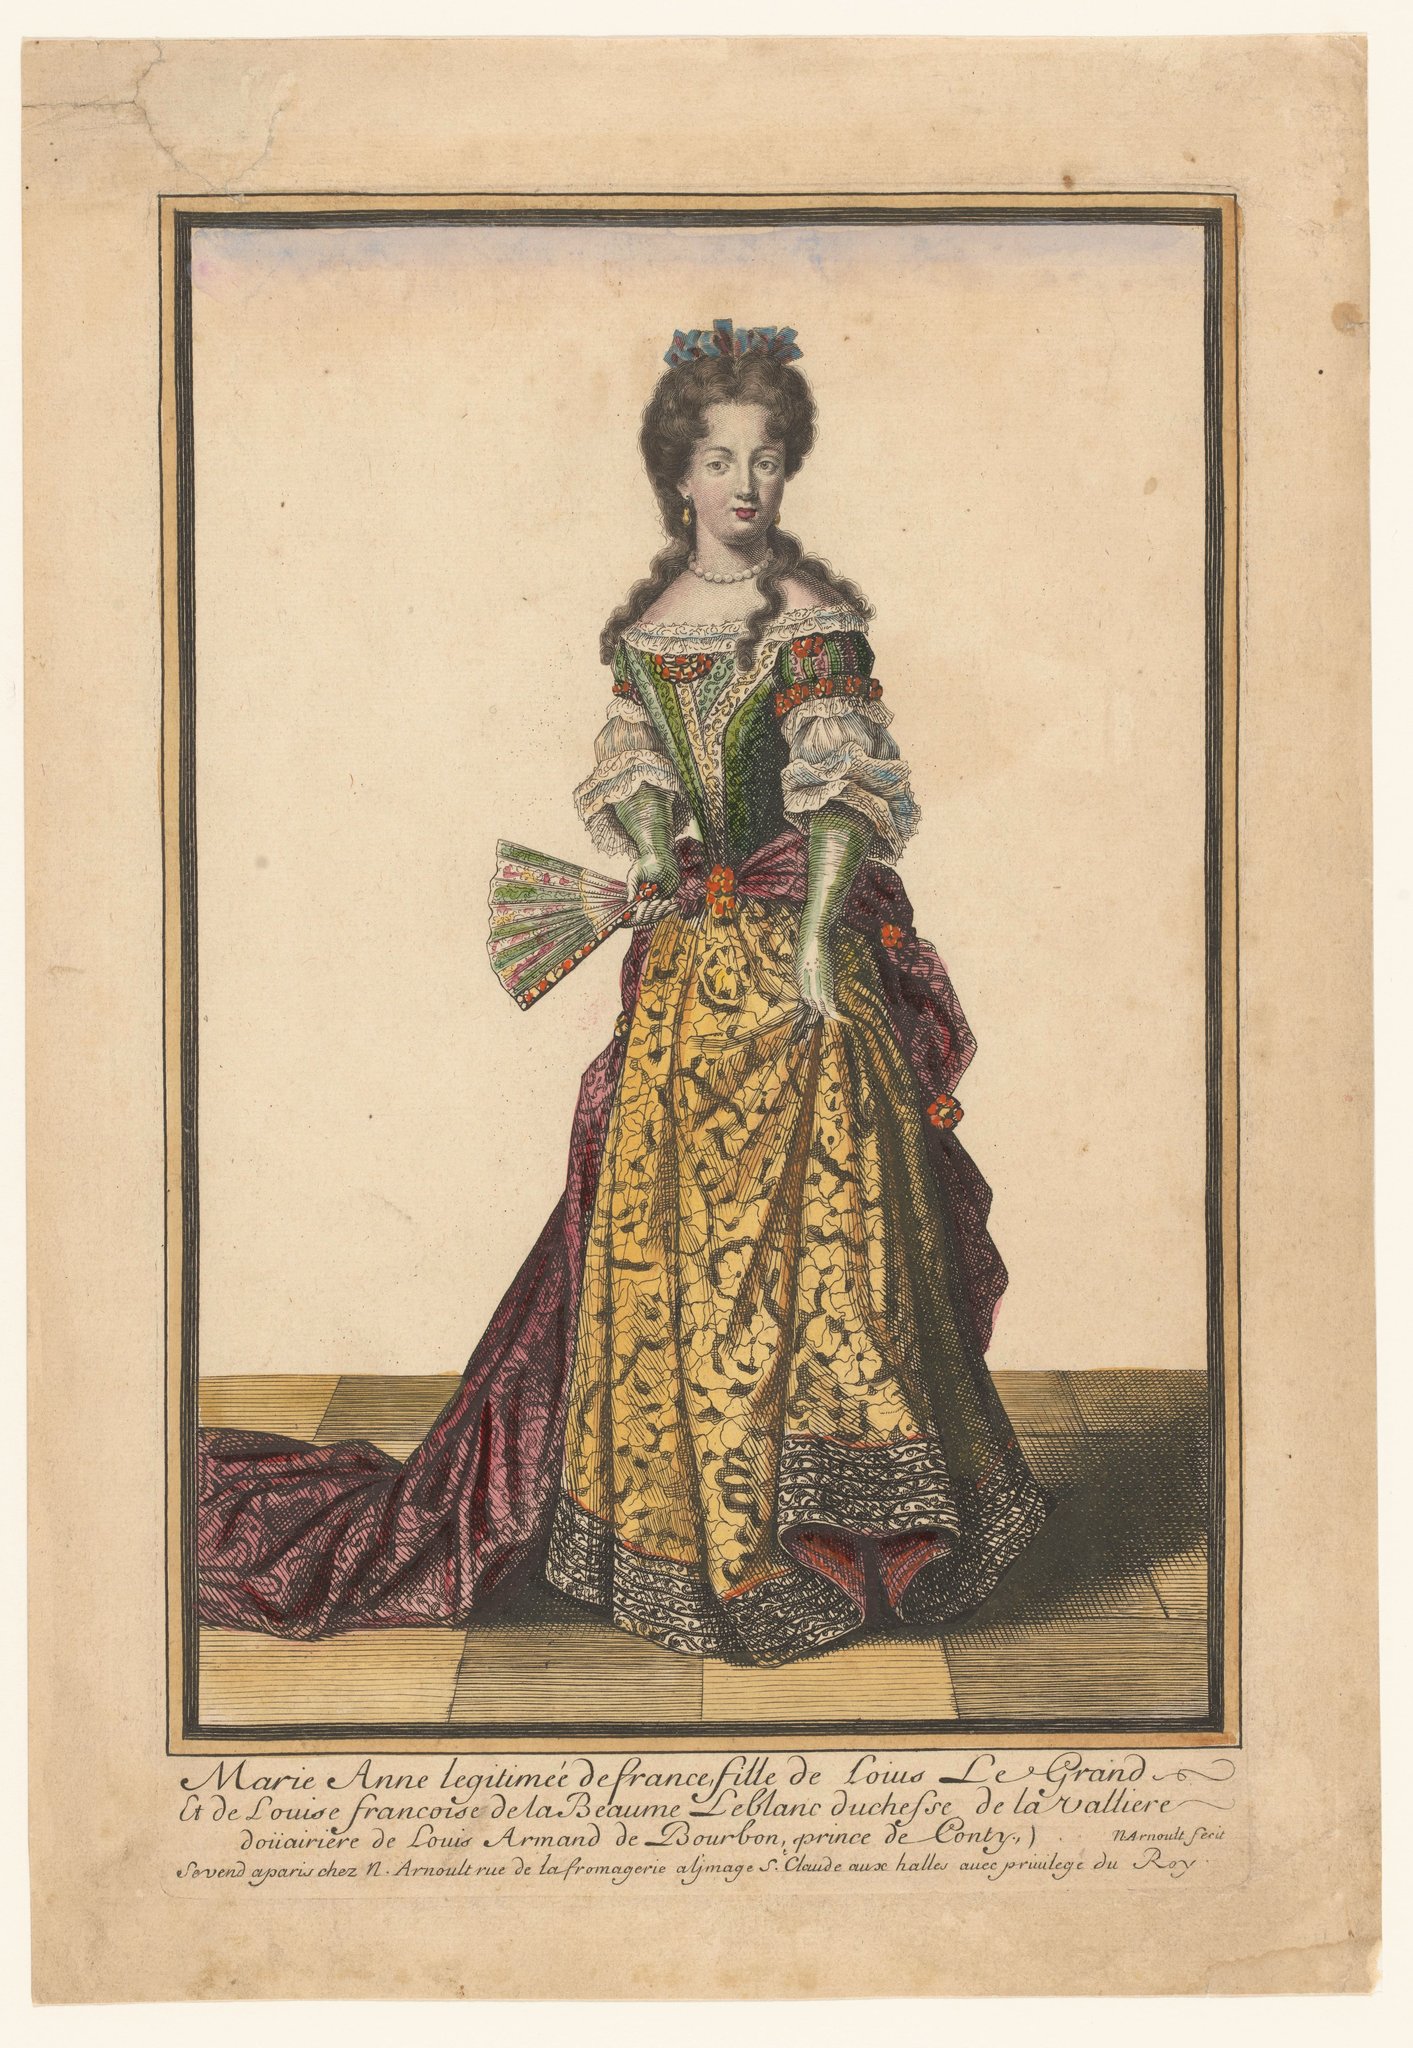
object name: fashion print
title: Marie Anne légitimée de france , fille de Louis Le Grand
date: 1685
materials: lacquer, paper, ink, watercolor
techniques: engraving, etching, hand coloring, lacquer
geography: paris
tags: paris, marie anne de bourbon, ear-rings (+ women's clothes), gloves, mittens (long gloves) (+ women's clothes), fashion plates, dress, gown: manteau (+ women's clothes), clothing for the upper part of the body (with name) (+ women's clothes), pearl; pearl necklace (+ women's clothes)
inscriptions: title: ‘Marie Anne légitimée de france , fille de Louis Le Grand’, collector's mark: Lugt 2228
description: Dame in manteau, bestaande uit een goudkleurig kleed waarover een rode bovenrok met sleep. Waaier in de rechterhand. Kapsel met lange pijpenkrullen in de hals.